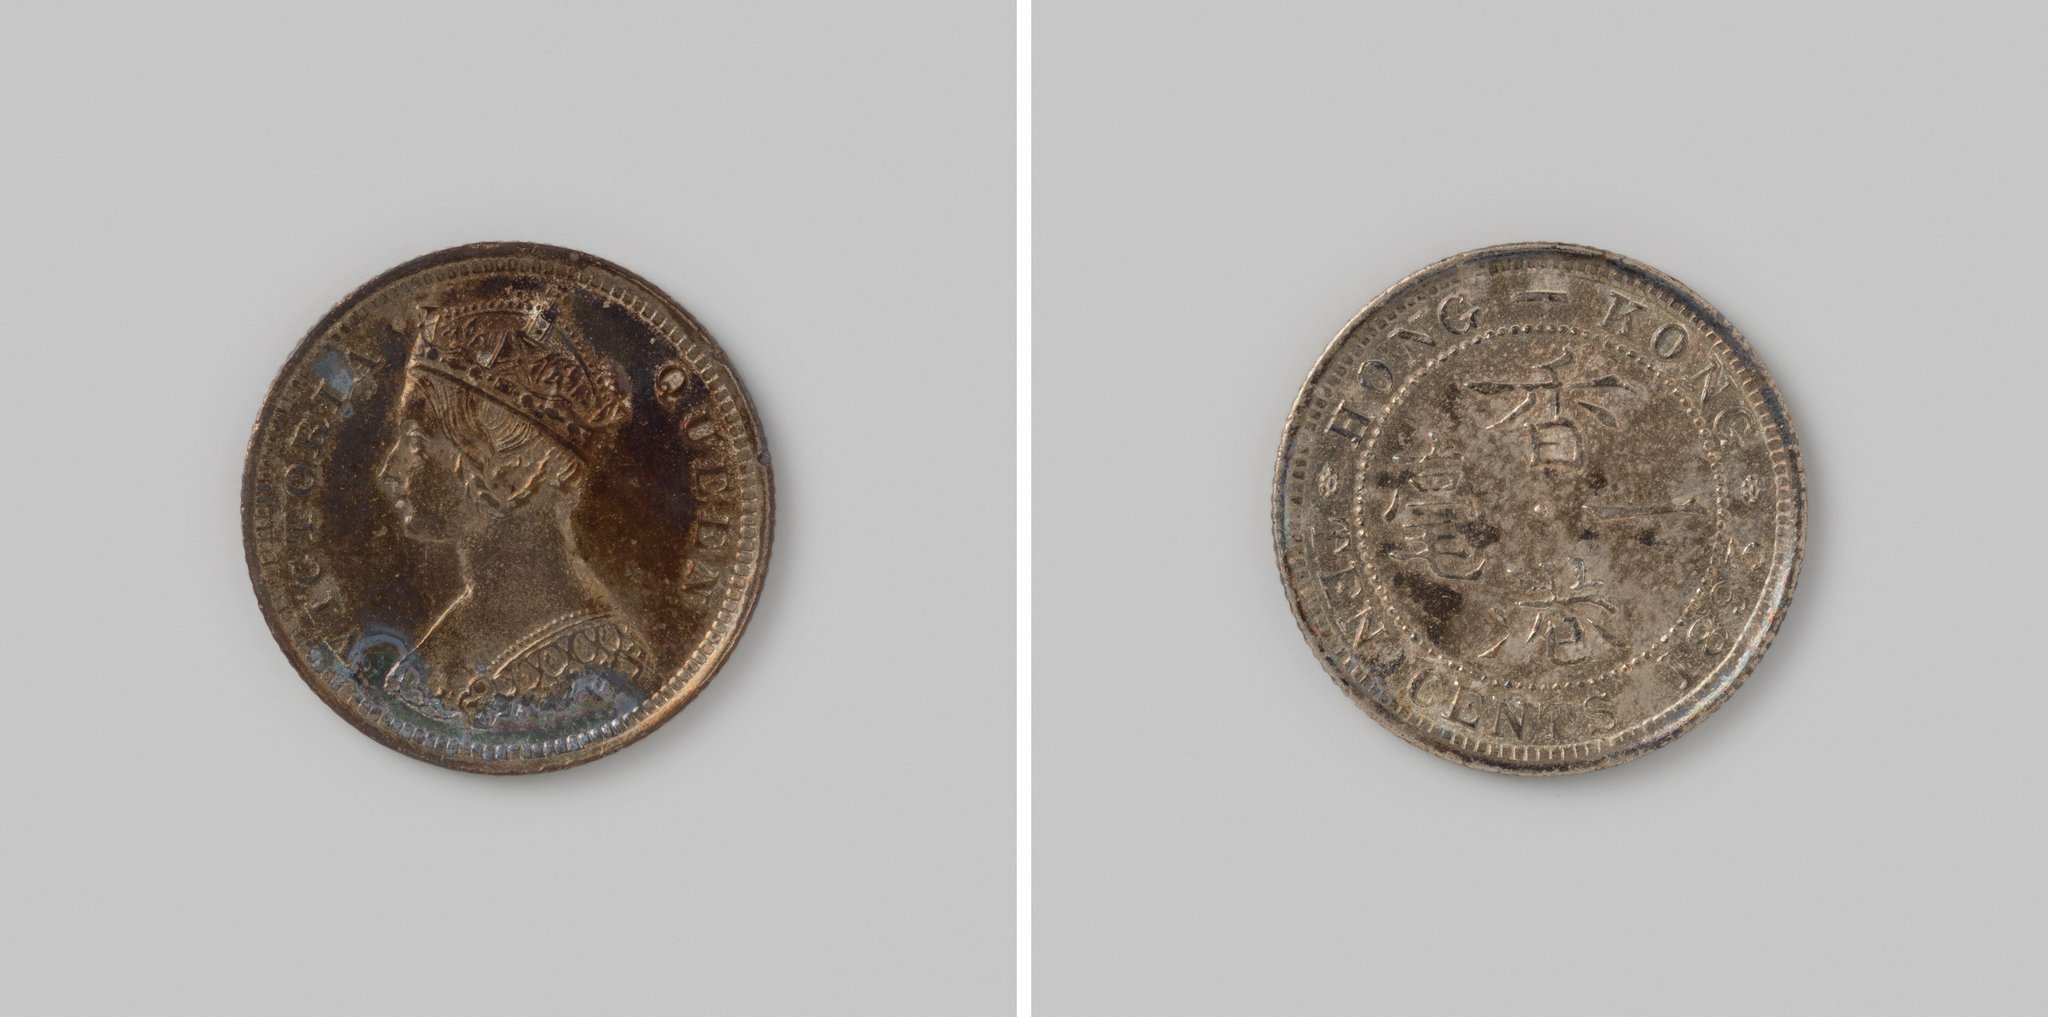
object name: coin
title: 10 cents uit Hongkong van koningin Victoria, 1893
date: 1893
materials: silver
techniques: striking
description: Zilveren munt. Voorzijde: gekroond borstbeeld van de koningin naar links. Keerzijde: in het omschrift waarde-aanduiding: 10 cents met rechts daarvan jaartal. Kartelrand.